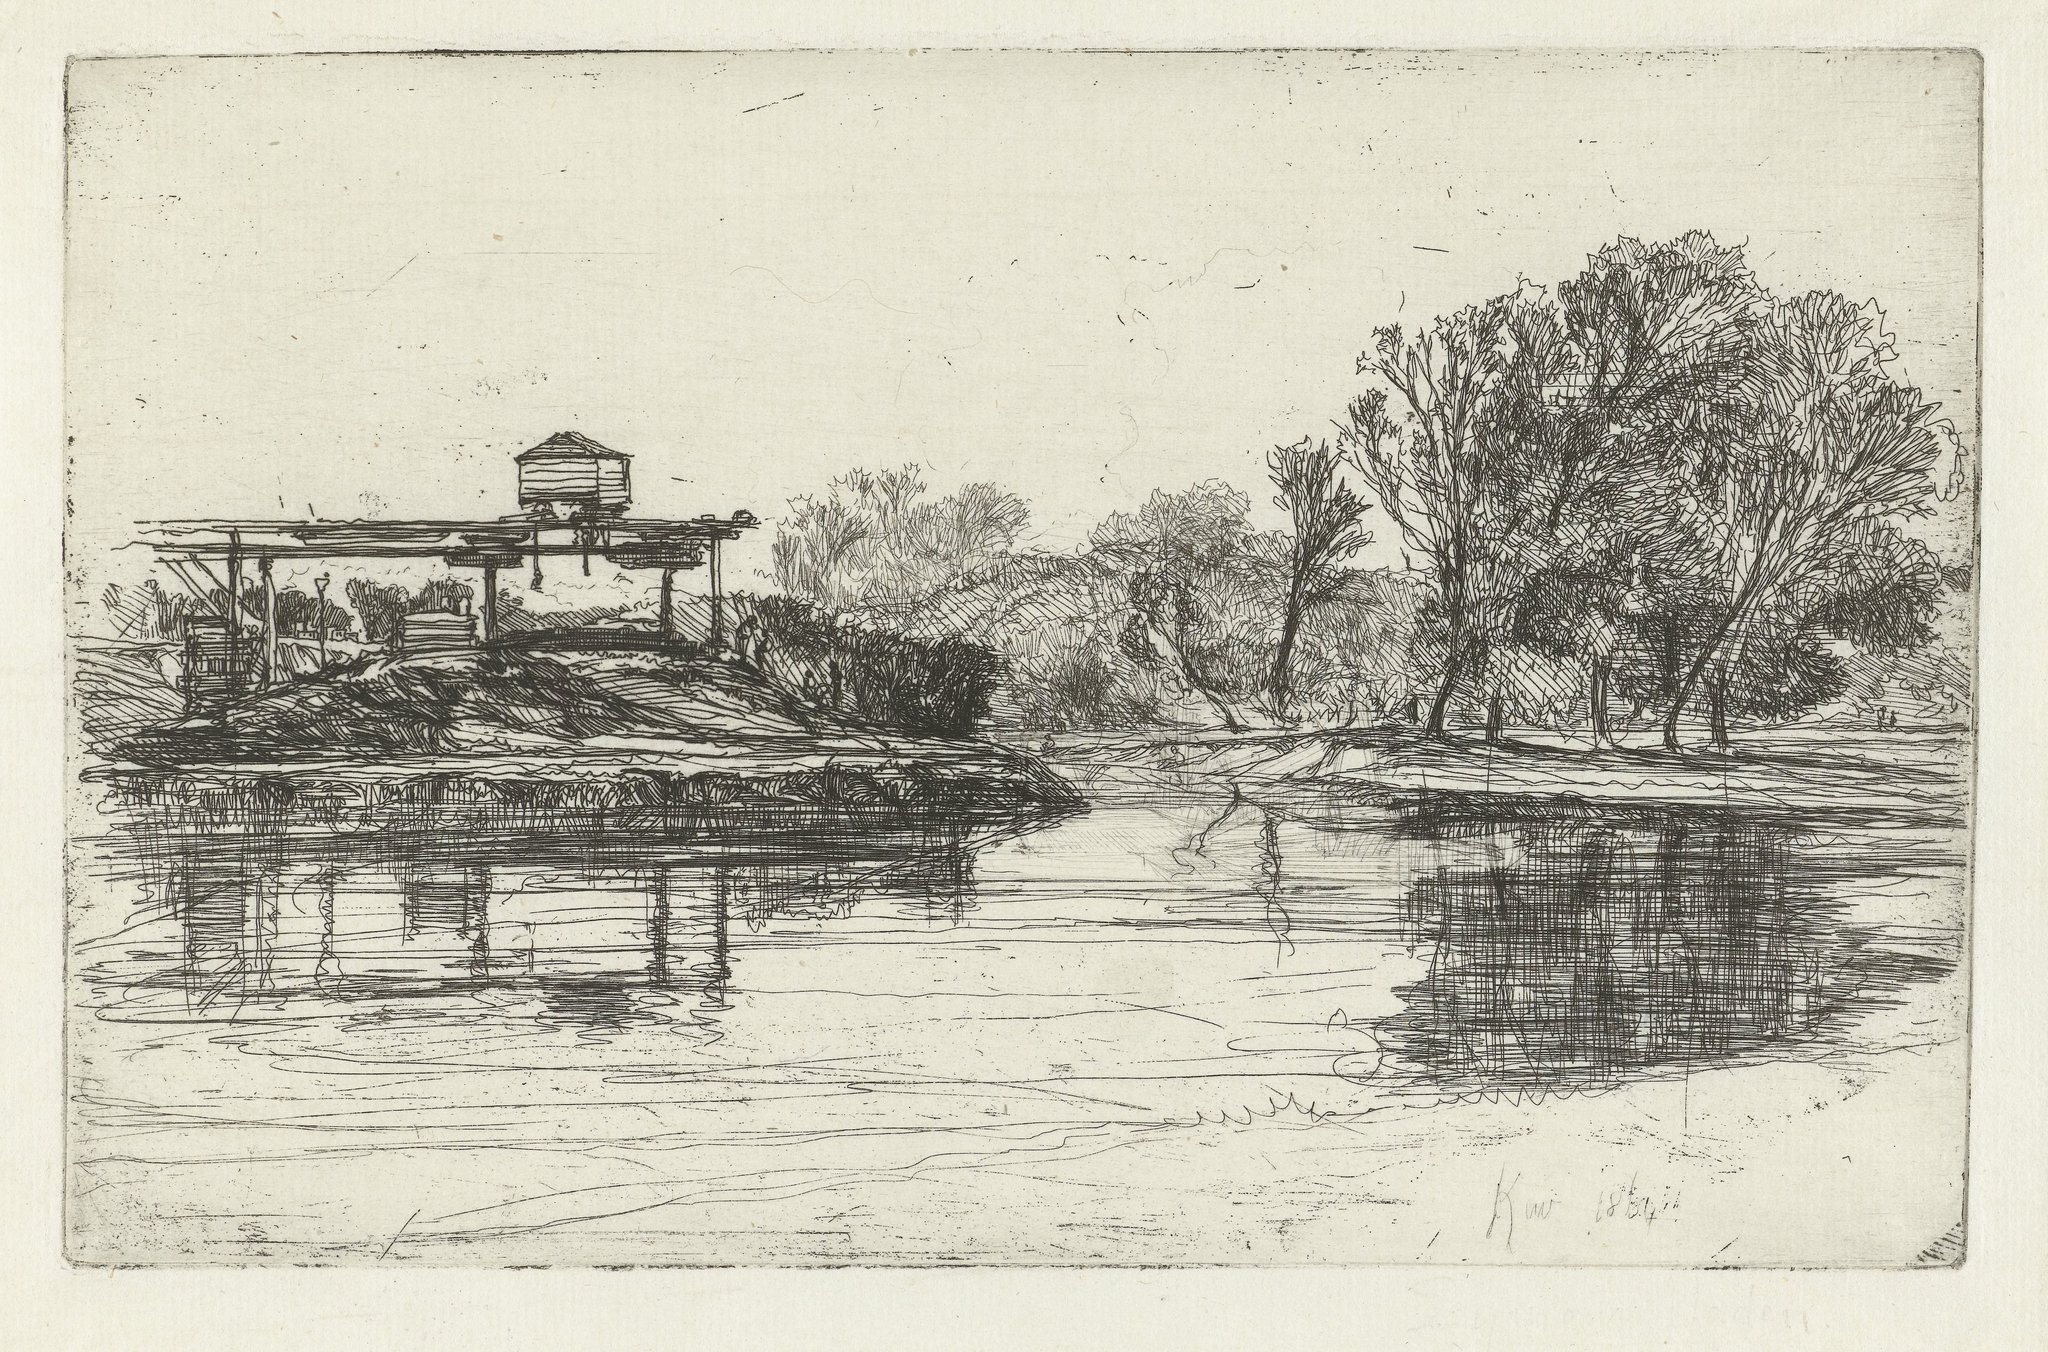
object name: print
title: Kew Railway Encroachment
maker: francis seymour-haden (sir)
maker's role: print maker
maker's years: 1818-1910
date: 1864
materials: paper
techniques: etching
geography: england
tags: landscape with bridge, viaduct or aqueduct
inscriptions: collector's mark: Lugt 2228, collector's mark: Lugt 2760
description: De rivier de Theems, met op de linker oever de Kew spoorwegbrug in aanbouw.